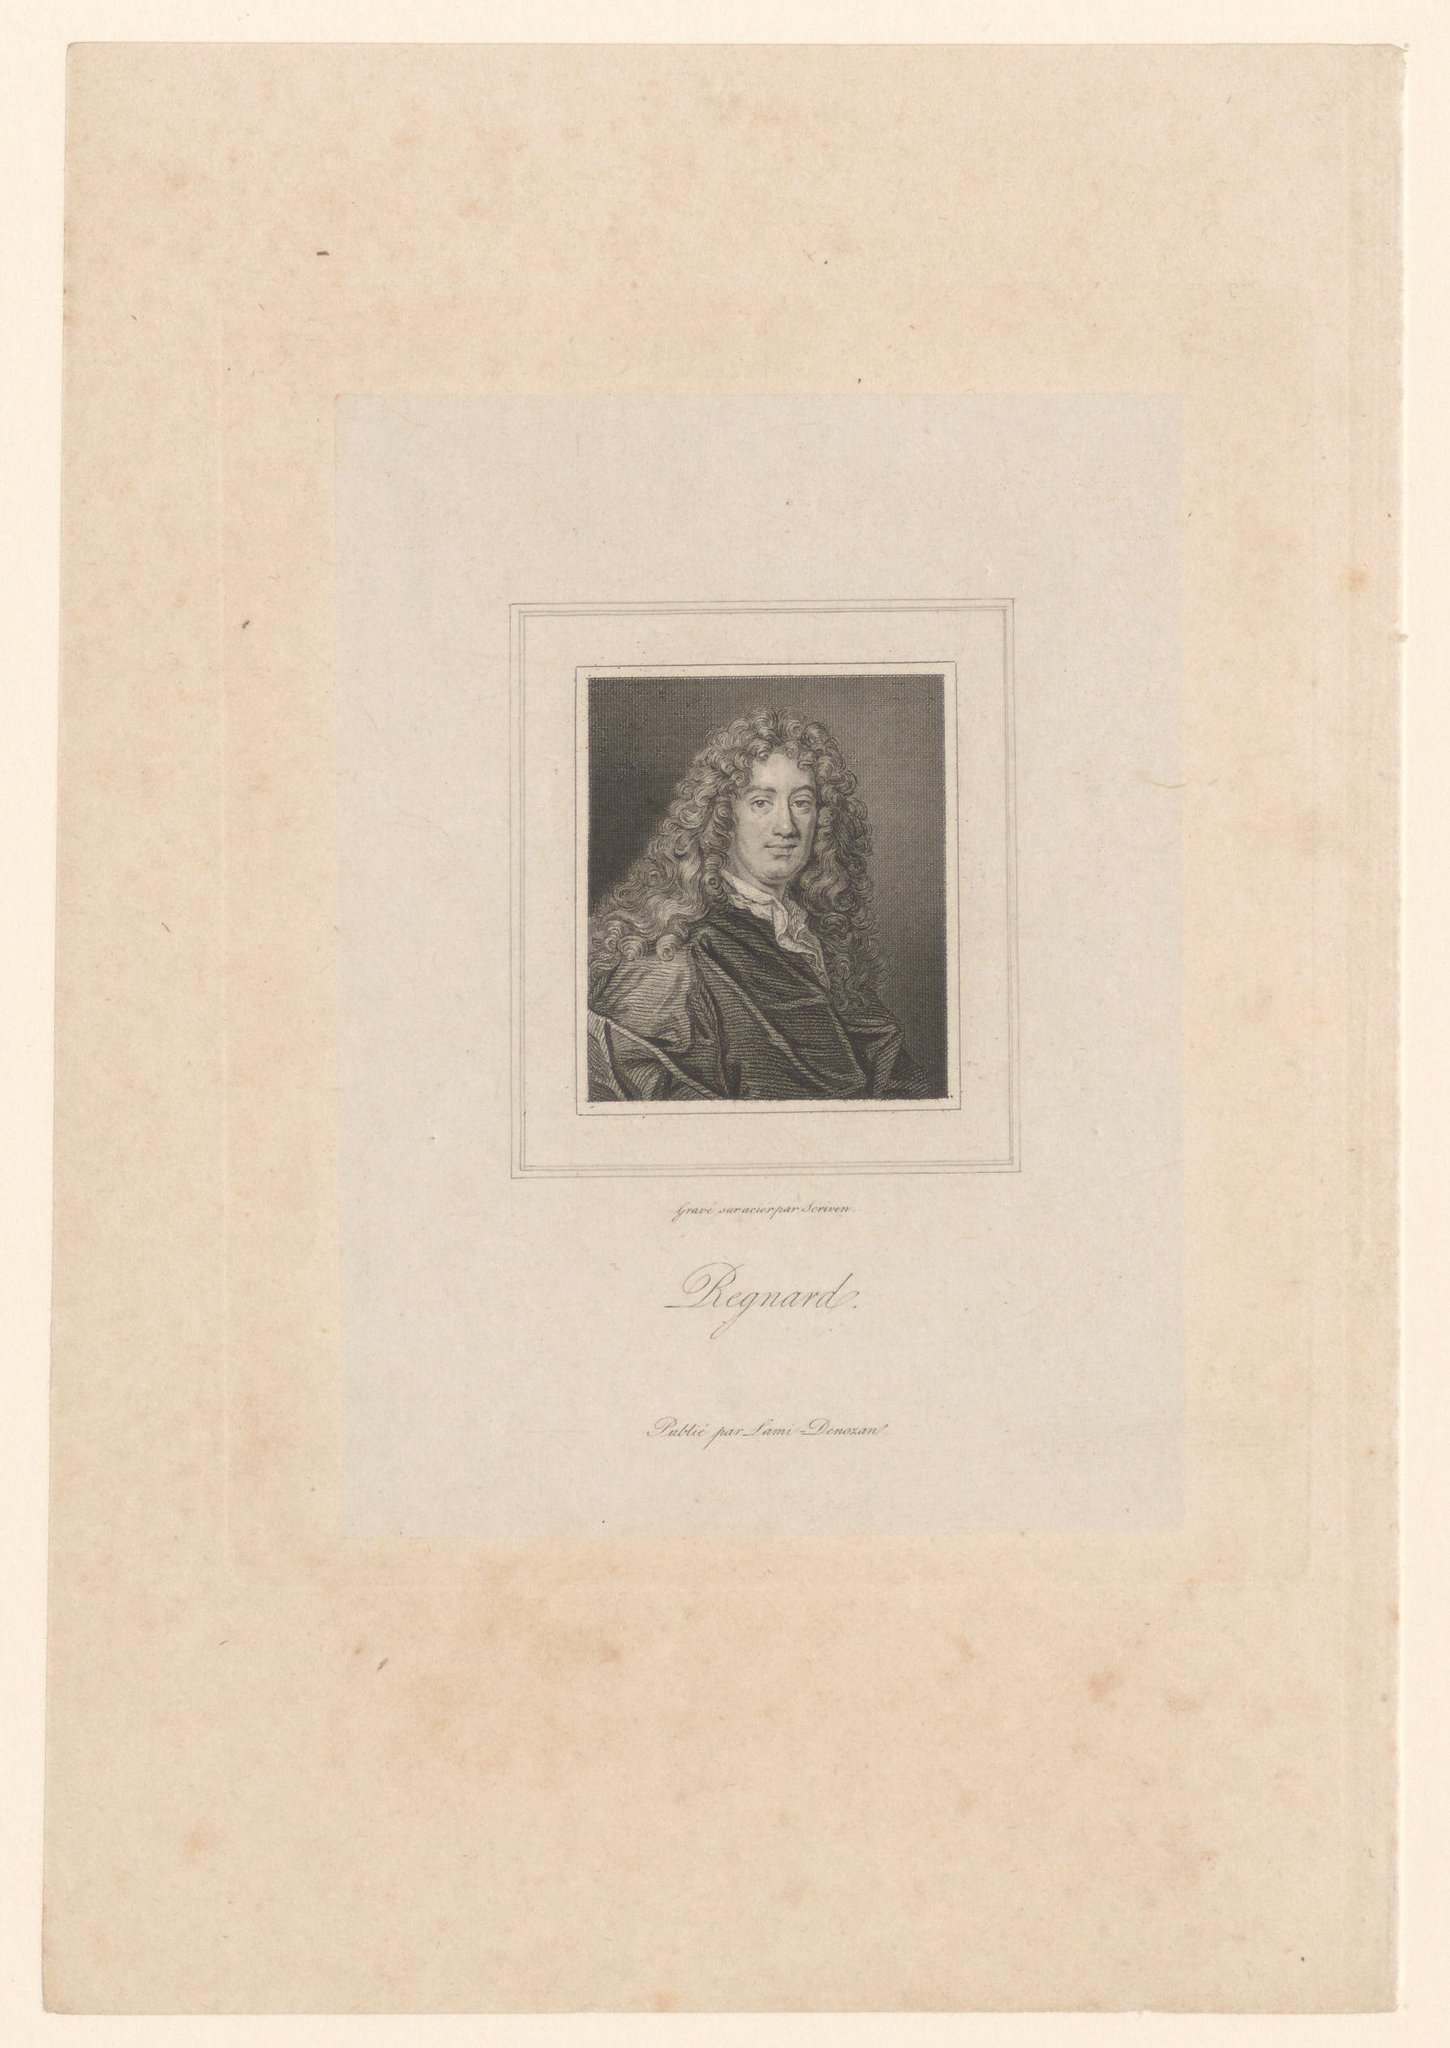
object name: print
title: Portret van Jean François Regnard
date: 1826-1841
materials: paper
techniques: etching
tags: paris, historical persons, portrait of composer, writer, poet, author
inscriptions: collector's mark: Lugt 2228